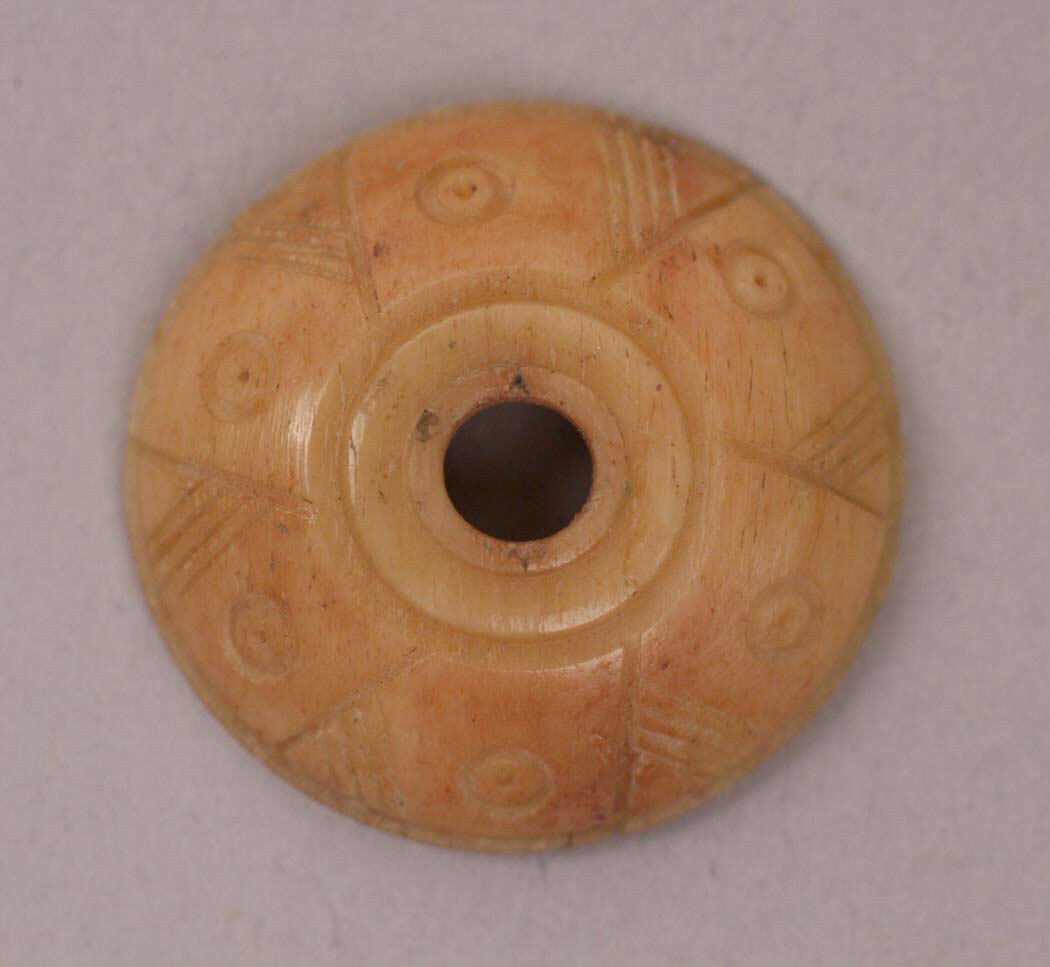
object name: button or bead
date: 801-1000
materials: bone, paint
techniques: incising, inlay, tinting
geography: iran